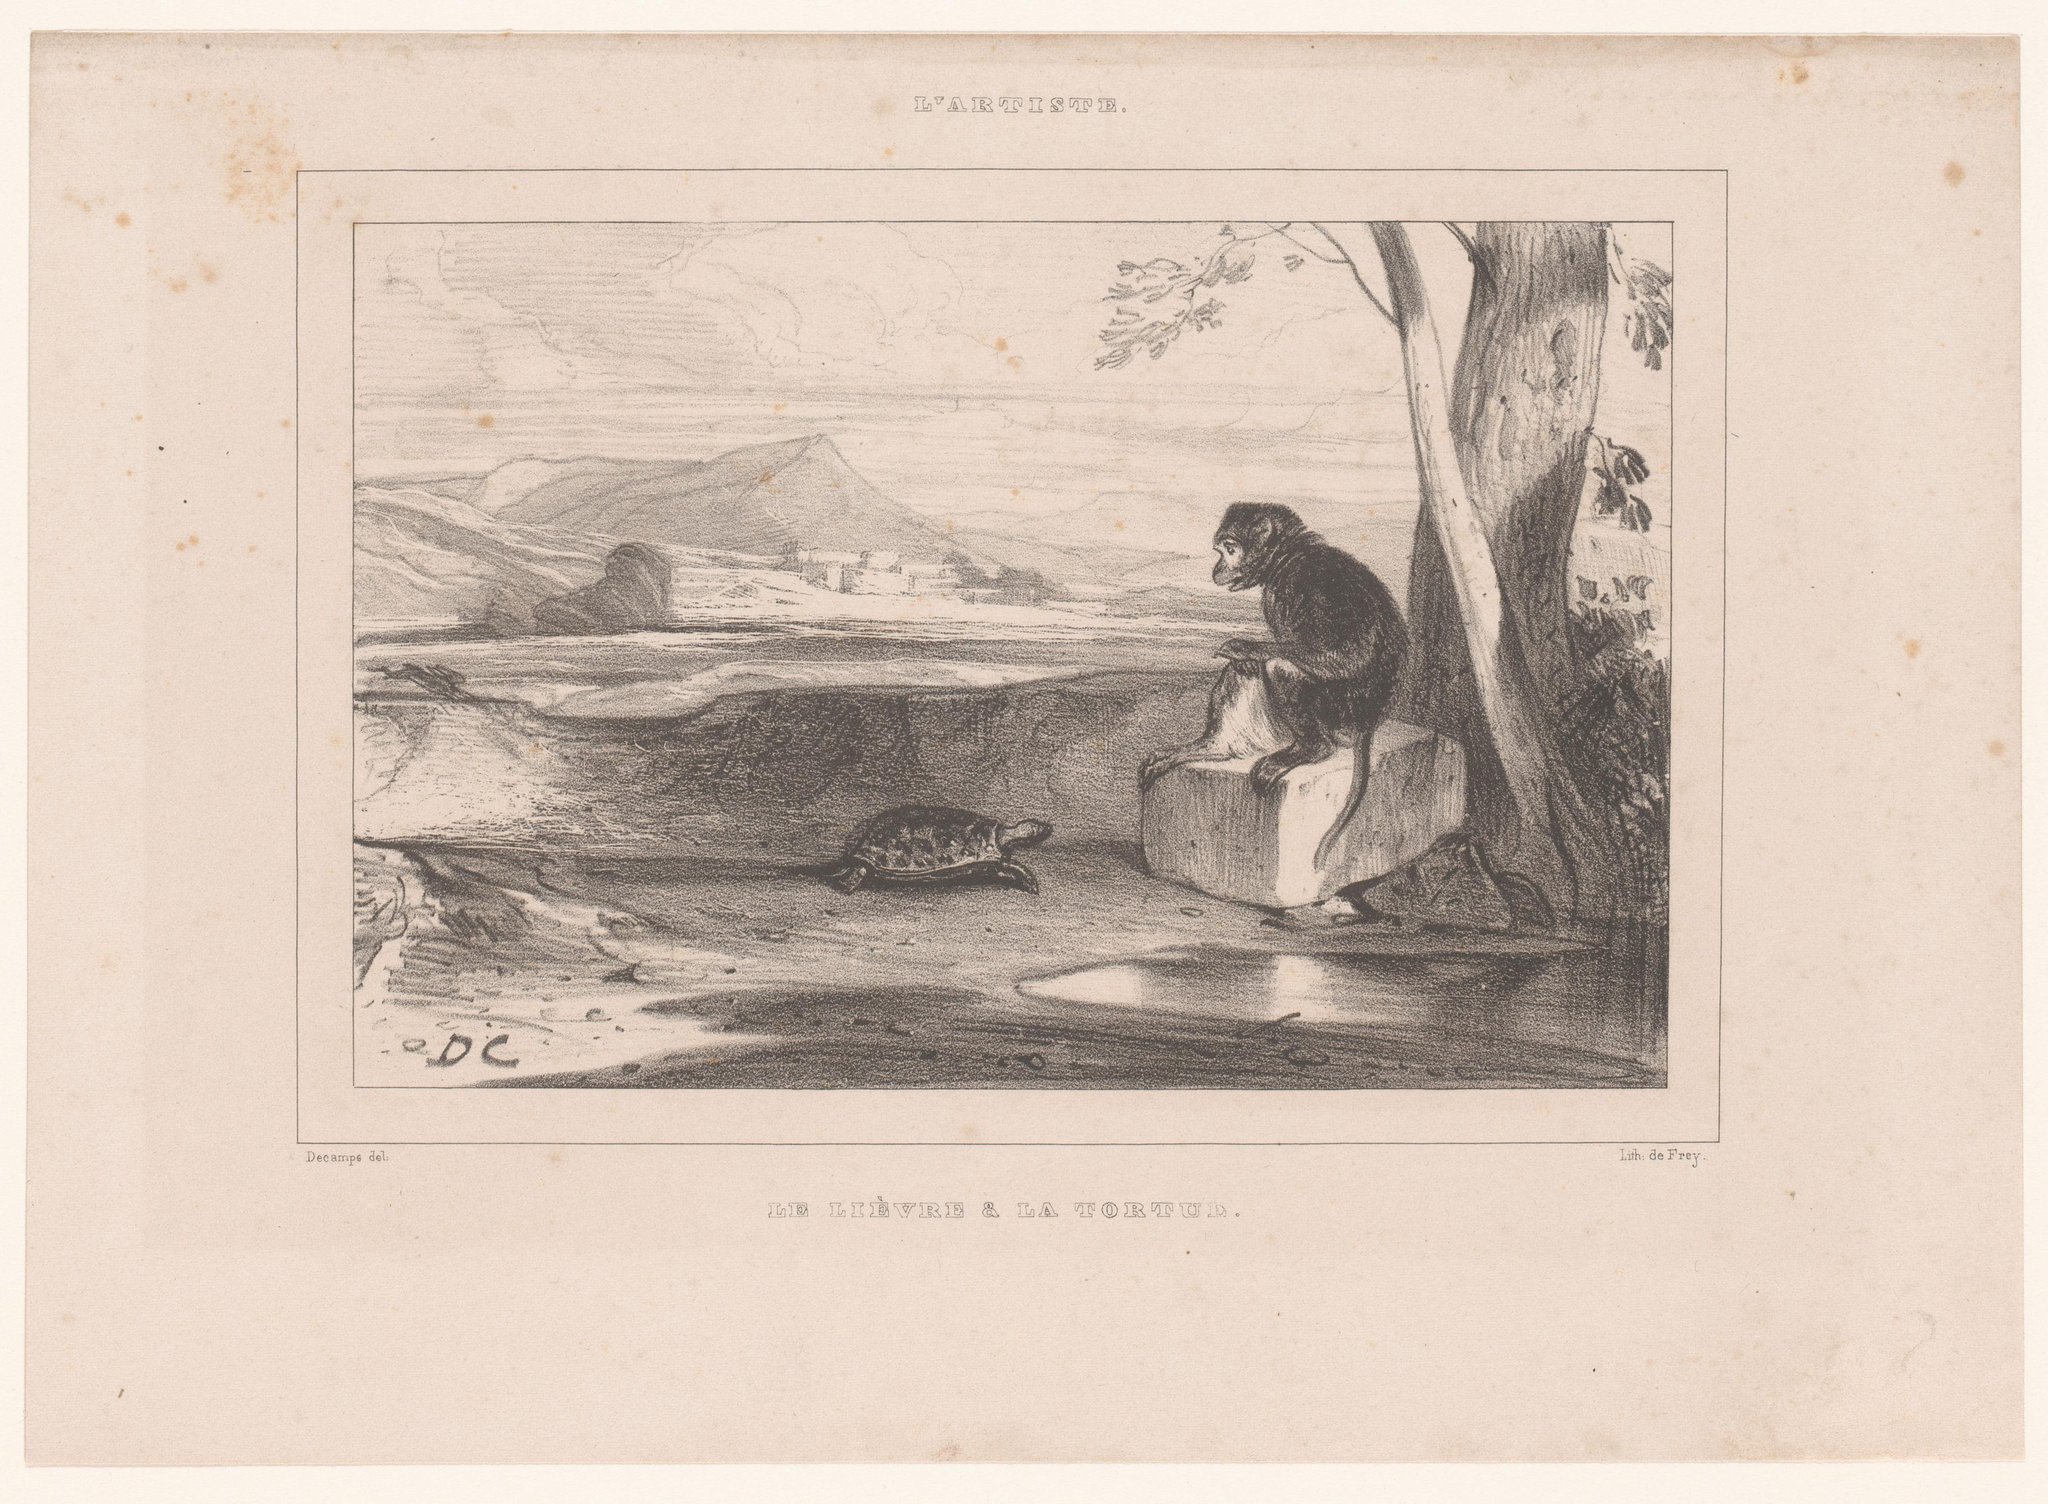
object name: print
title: Le lièvre et la tortue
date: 1836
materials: paper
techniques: lithograph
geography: paris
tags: monkeys, apes, running, race, fables (with title) (+ variant)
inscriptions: collector's mark: Lugt 2228a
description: Prent gebruikt voor: L'Artiste, journal de la littérature et des beaux-arts 11 (1836). L'Artiste was een geïllustreerd weekblad dat verscheen tussen 1831 en 1904.